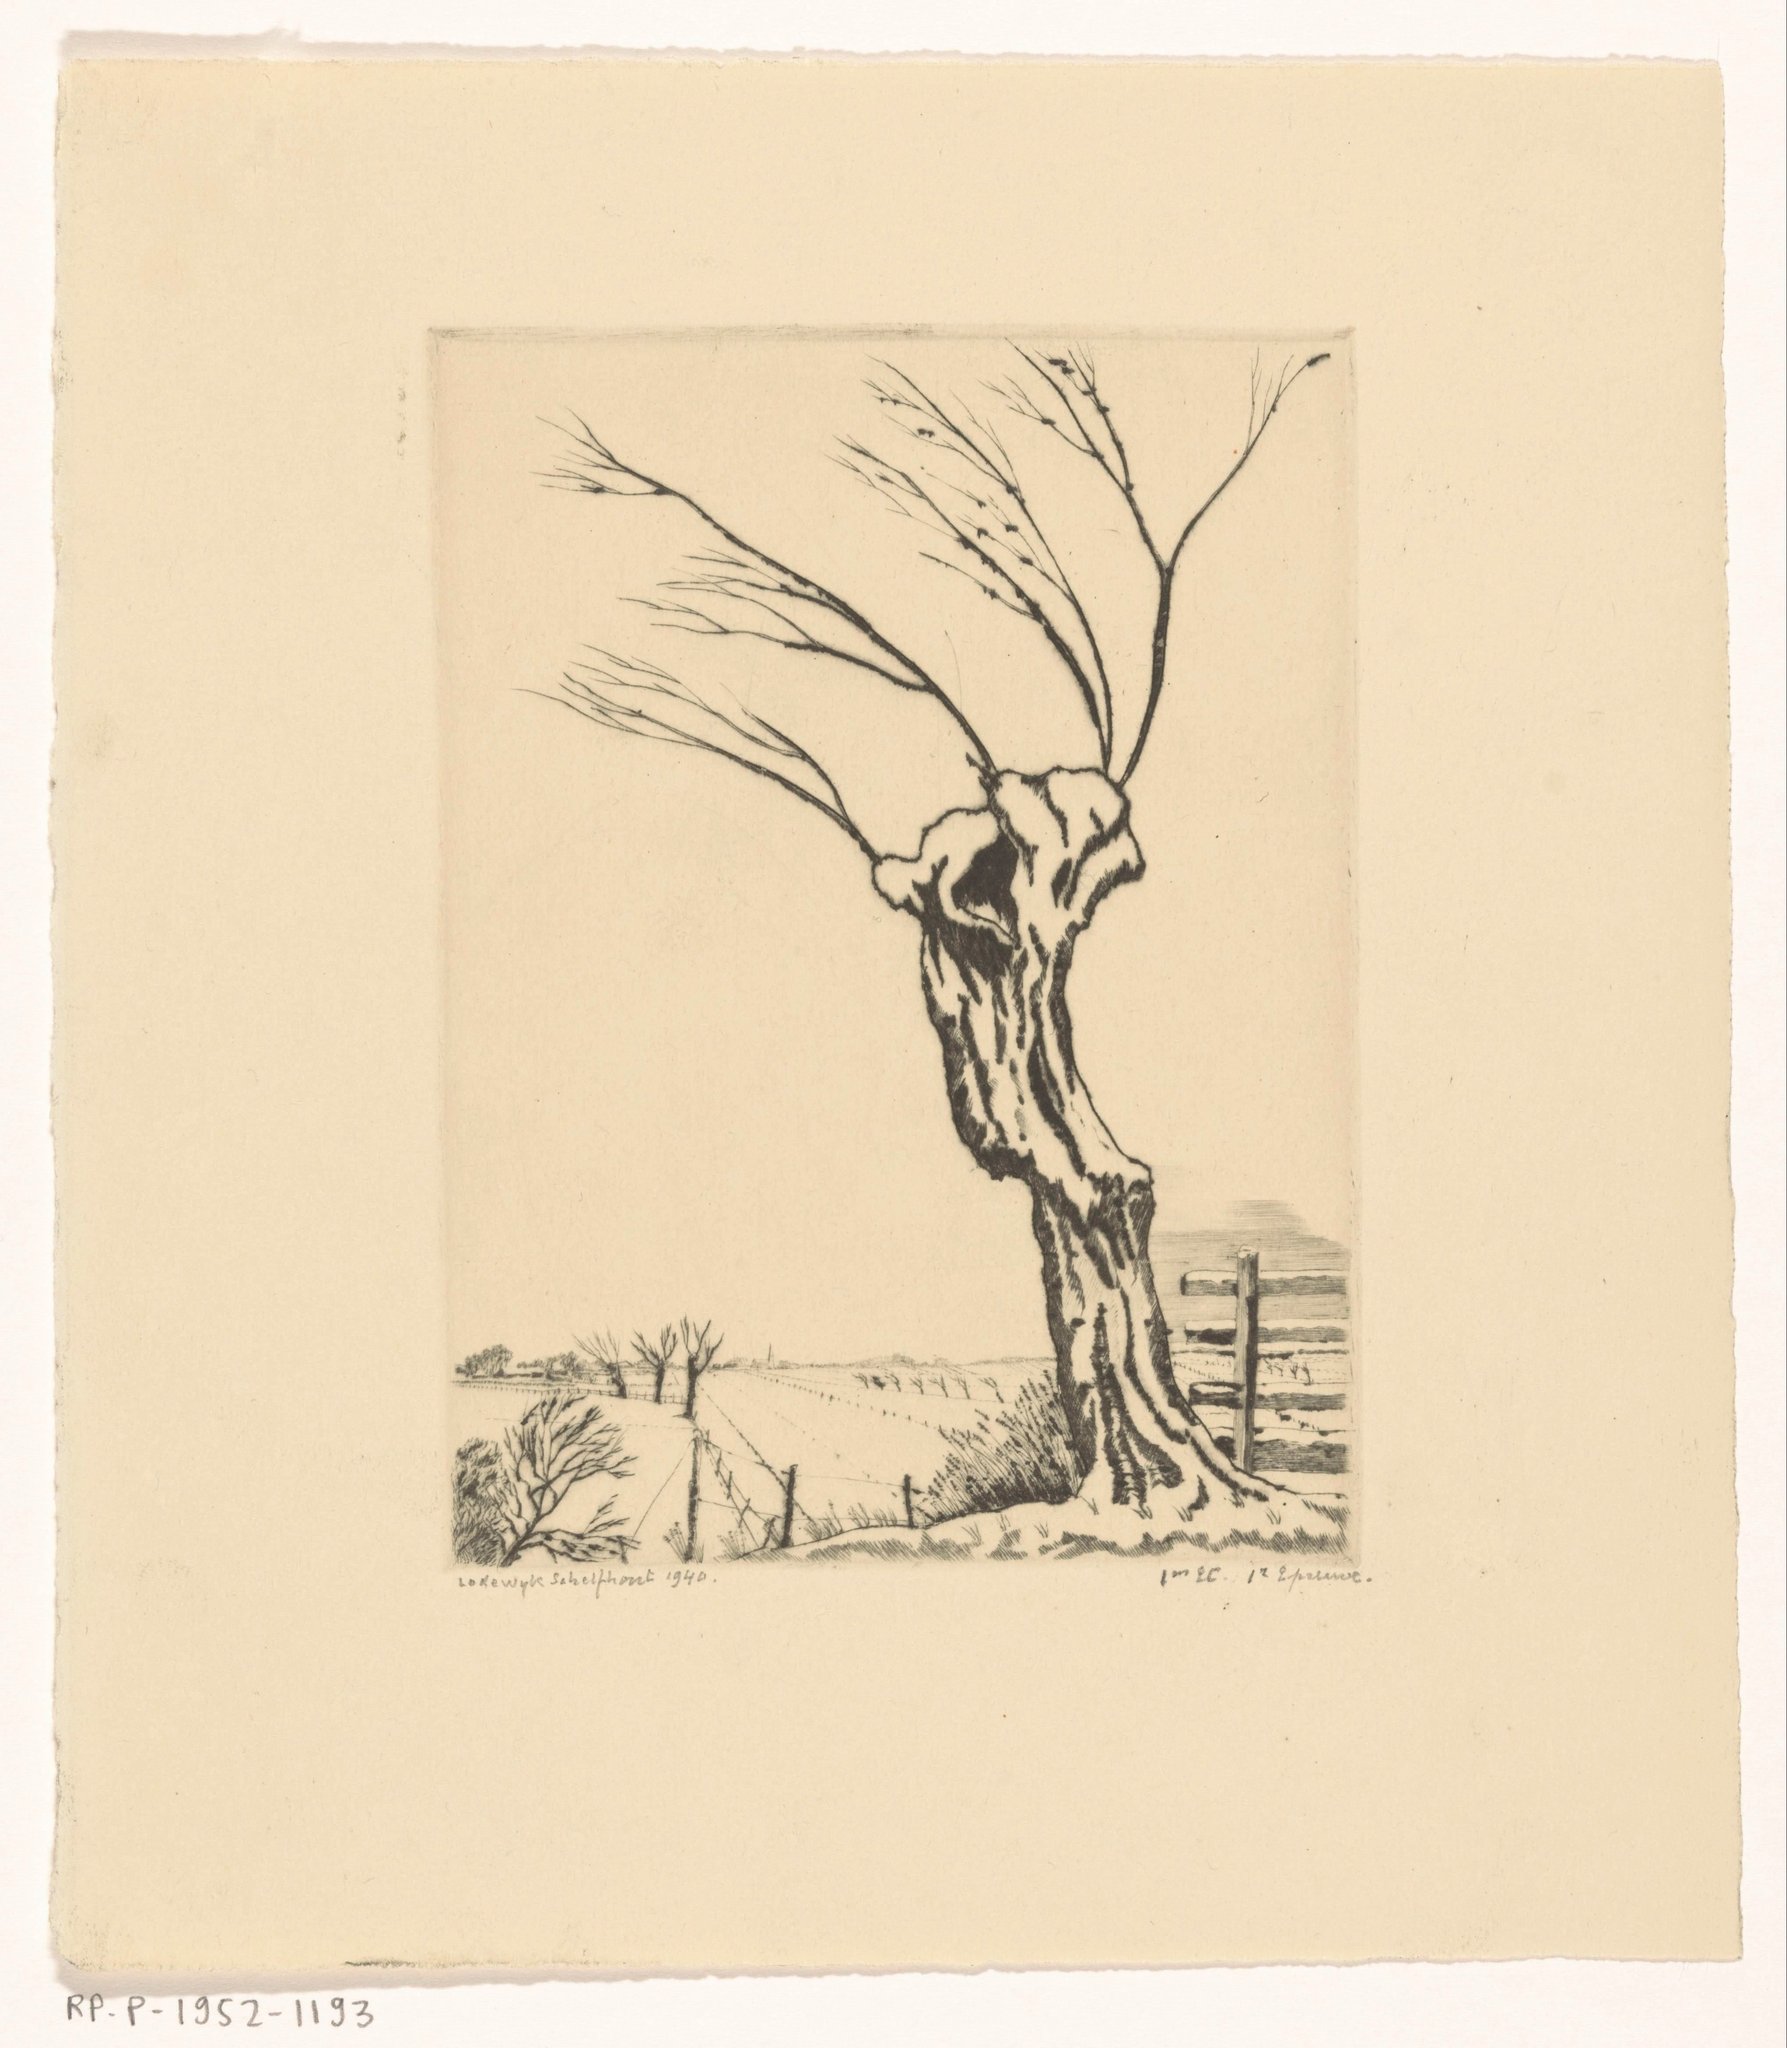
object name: print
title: Wilg in een winterlandschap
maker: lodewijk schelfhout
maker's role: draughtsman, print maker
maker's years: 1881-1943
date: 1940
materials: paper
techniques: drypoint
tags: snow, trees: willow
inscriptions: collector's mark: Lugt 2228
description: Een knotwilg naast een hek in een besneeuwd landschap met akkers.